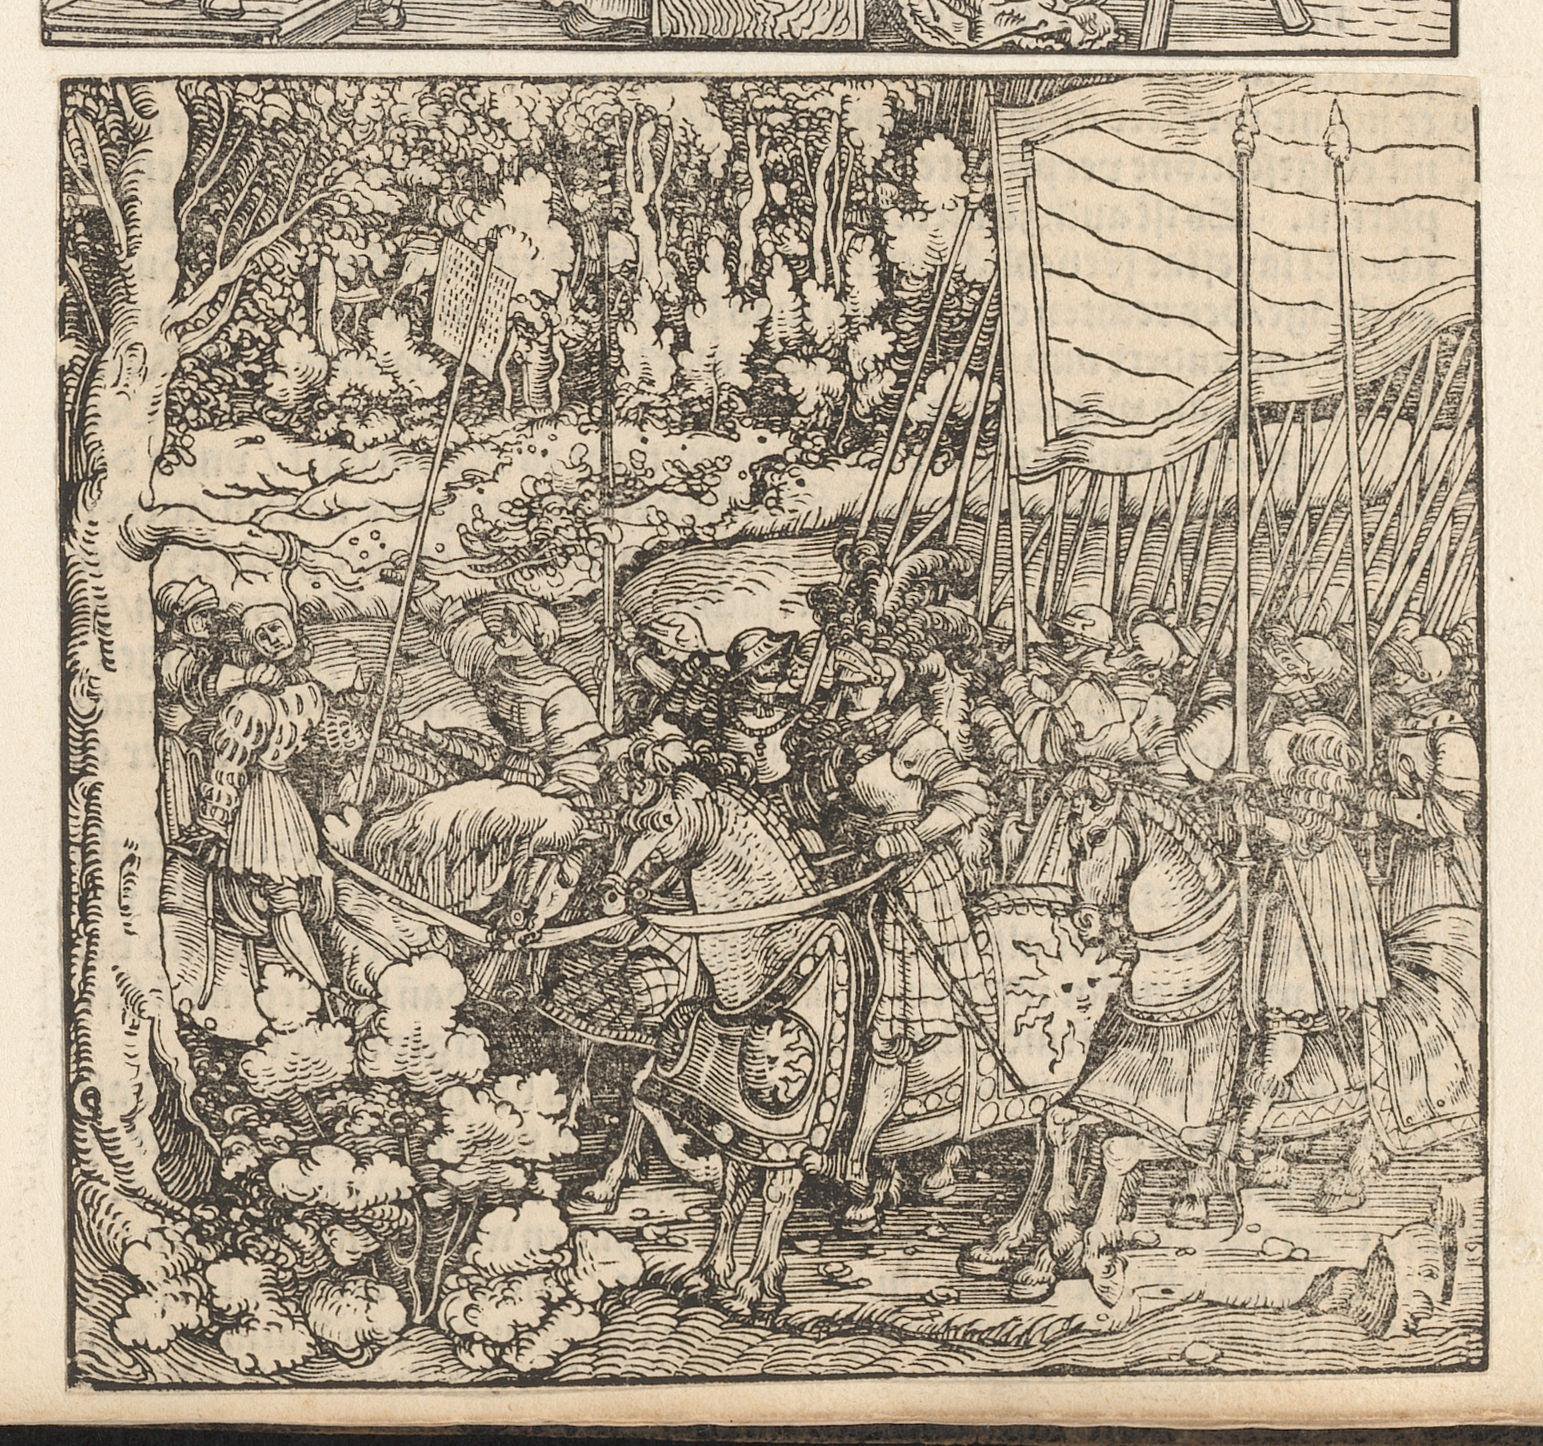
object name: book illustration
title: Soldaten bij een bos waar iemand aan een boom wordt opgehangen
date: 1514-1532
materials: paper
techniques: letterpress printing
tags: army 'en route', troop movements, transportation, violent death by hanging, private soldier (+ infantry)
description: Deze prent is gebruikt in: Petrarca, Francesco. Von der Artzney bayder Glück, des guten und widerwertigen: unnd weß sich ain yeder inn Gelück und Unglück halten sol (...). Augsburg: Heinrich Steiner, 1532. Deze uitgave is ook bekend onder de titel 'Trostspiegel in Glück und Unglück'. Deze prent is ook gebruikt in: Cicero, Marcus Tulius. Officia M.T.C. Ein Buch so Marcus Tullius Cicero der Römer zu seynem (...). [Vertaald uit het Latijn door] Johann von Schwarzenberg. Augsburg: Heinrich Steiner, 1531.